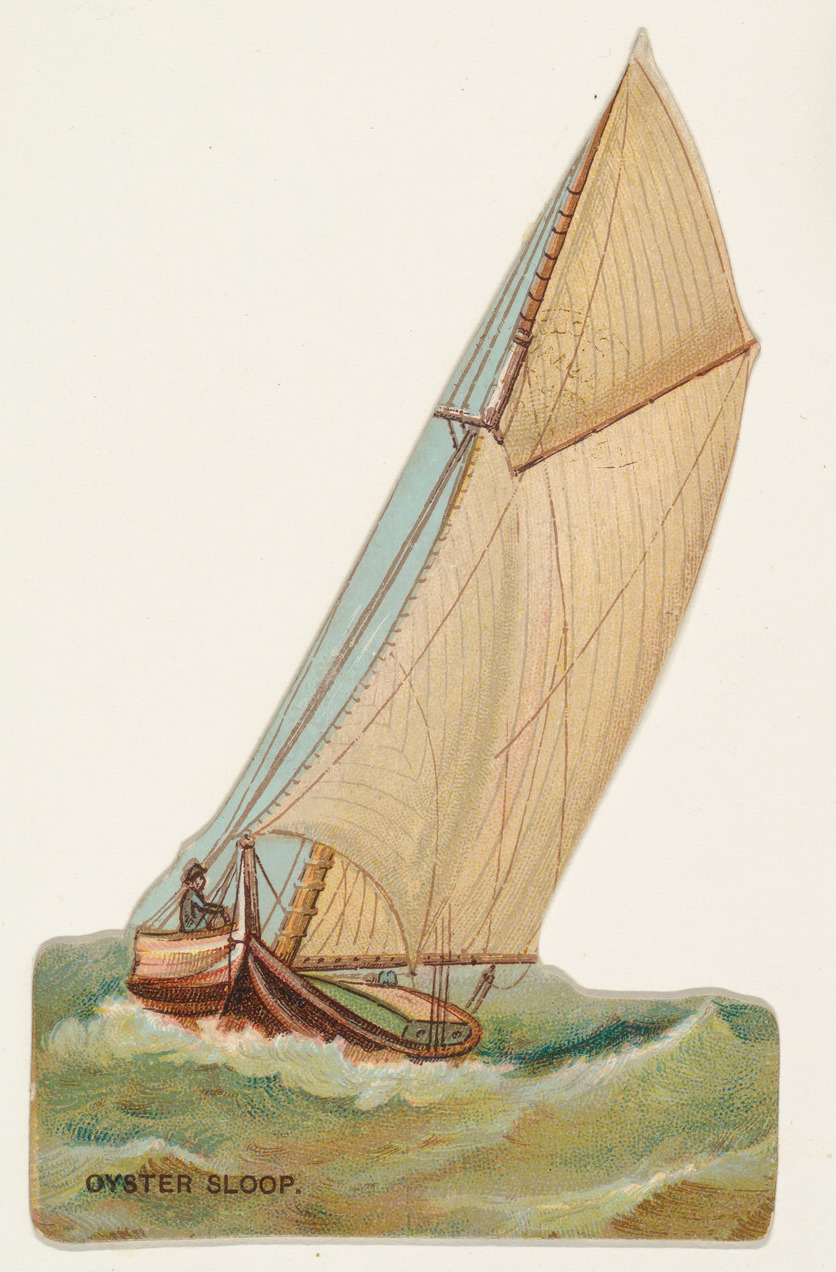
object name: print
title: Oyster Sloop, from the Types of Vessels series (N139) issued by Duke Sons & Co. to promote Honest Long Cut Tobacco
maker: w. duke, sons & co.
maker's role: publisher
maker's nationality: american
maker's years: 1870-1920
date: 1889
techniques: color lithograph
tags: ships